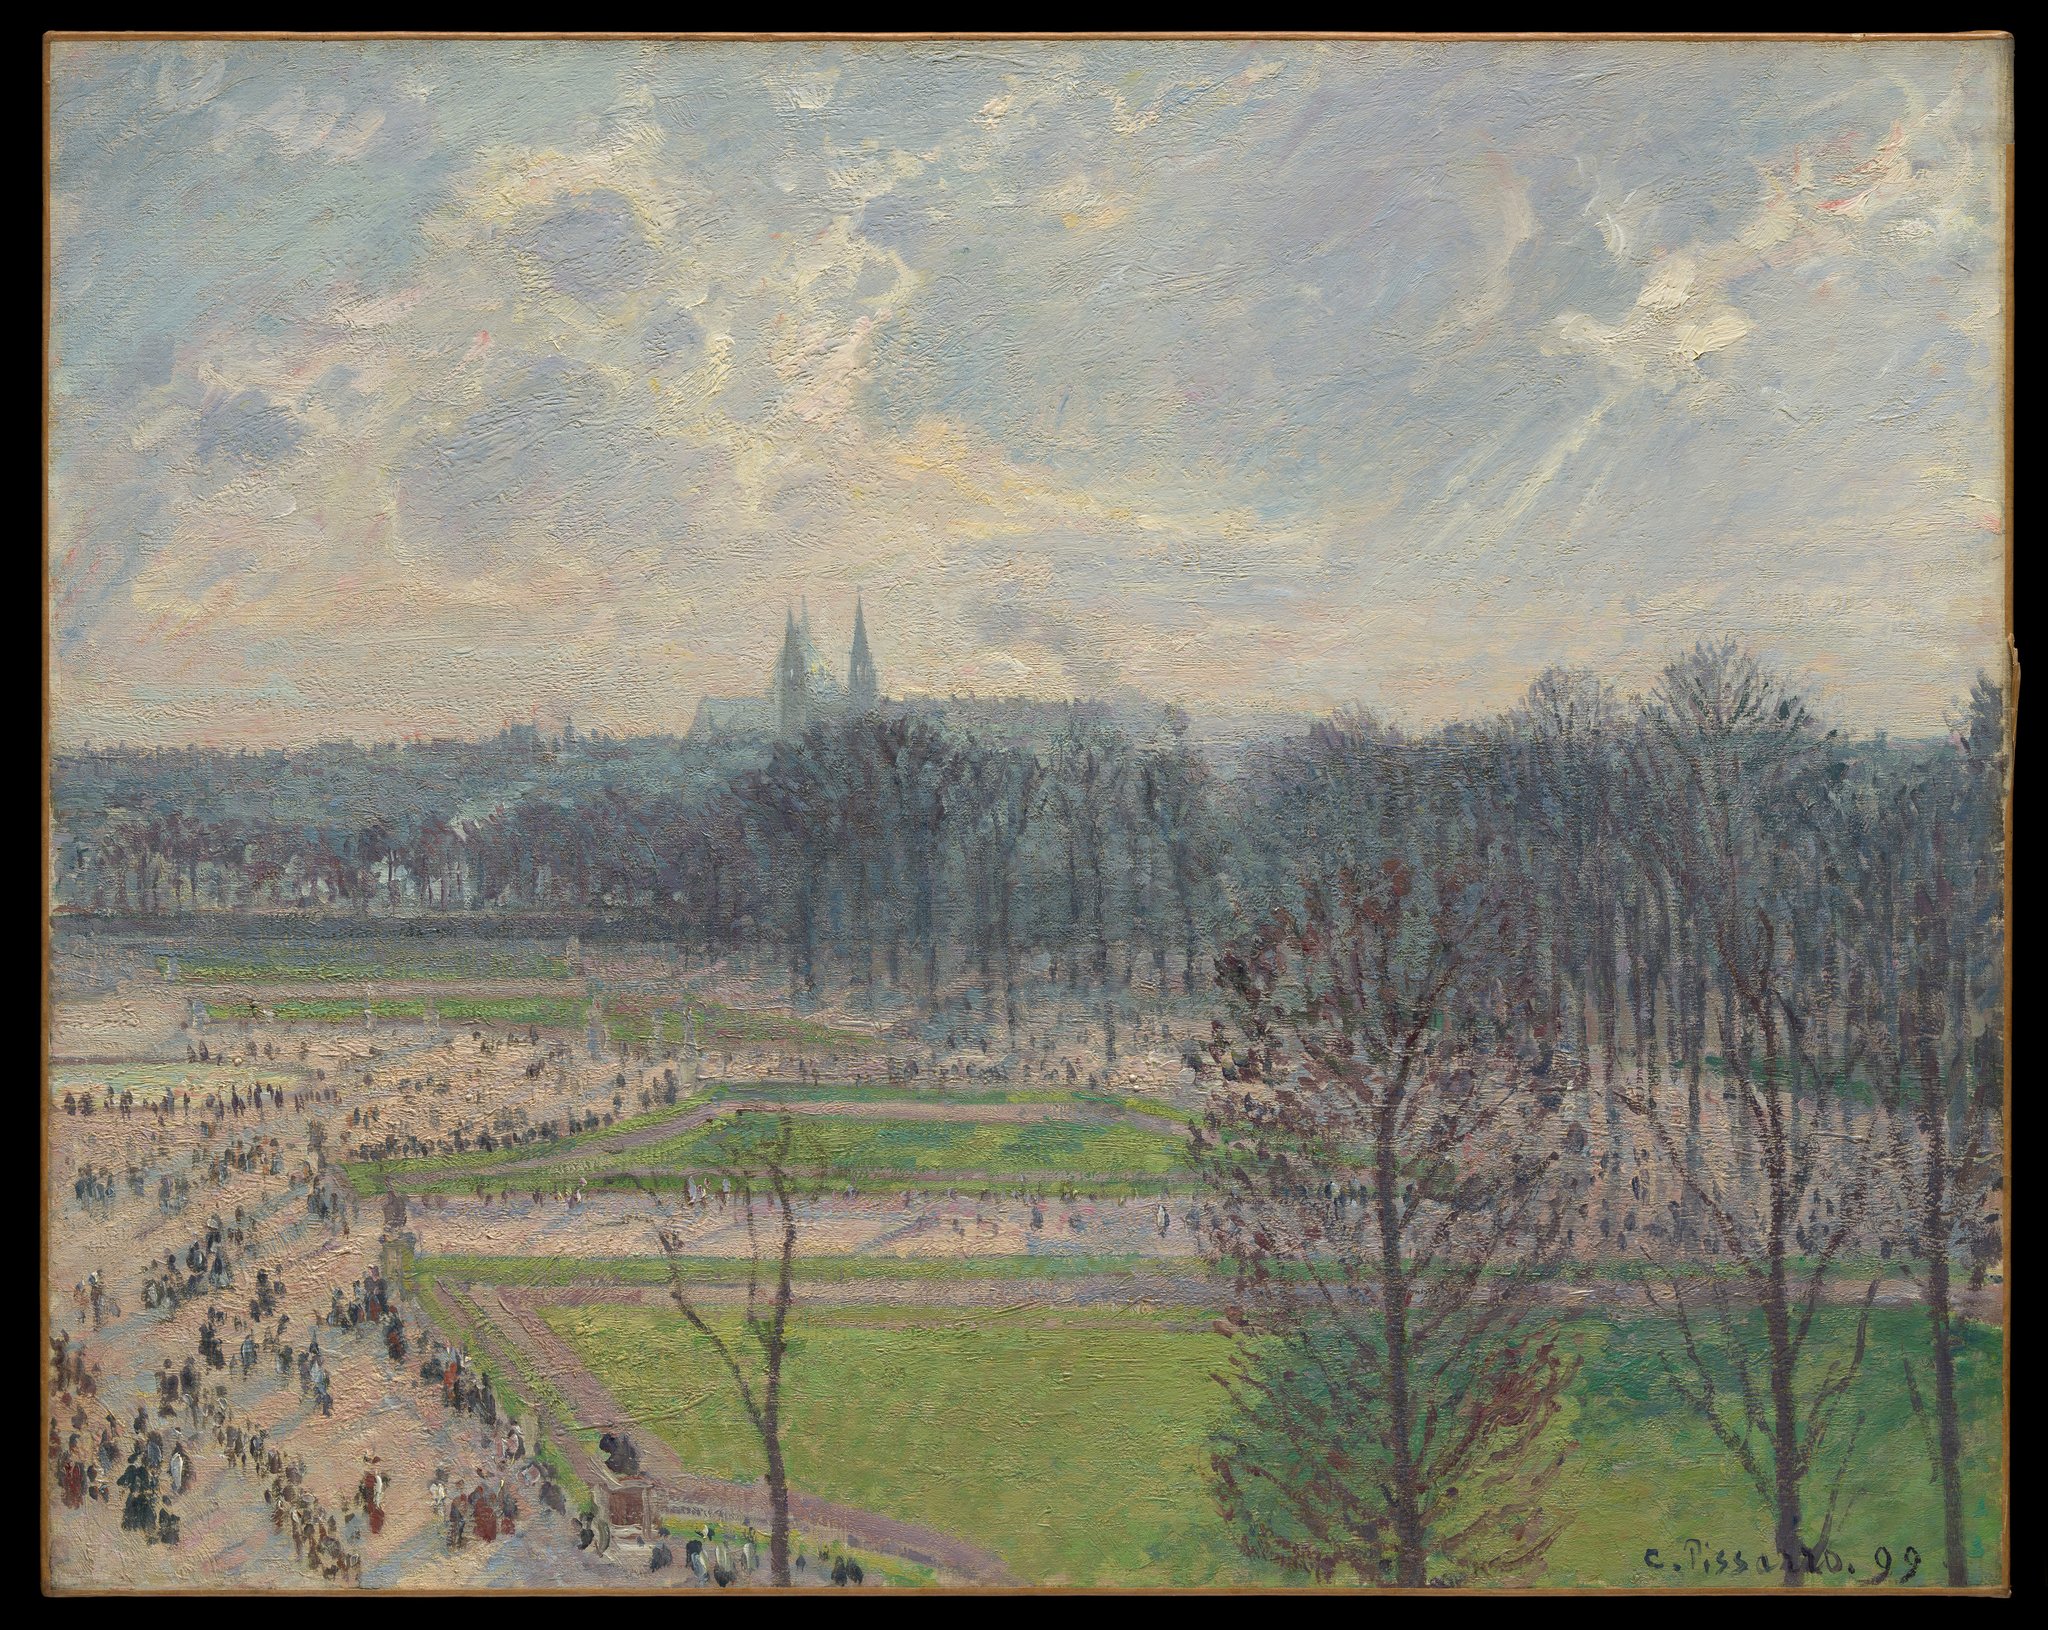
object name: painting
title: The Garden of the Tuileries on a Winter Afternoon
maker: camille pissarro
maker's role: artist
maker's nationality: french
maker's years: 1830-1903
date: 1899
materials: canvas, oil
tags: cities,gardens,winter,paris